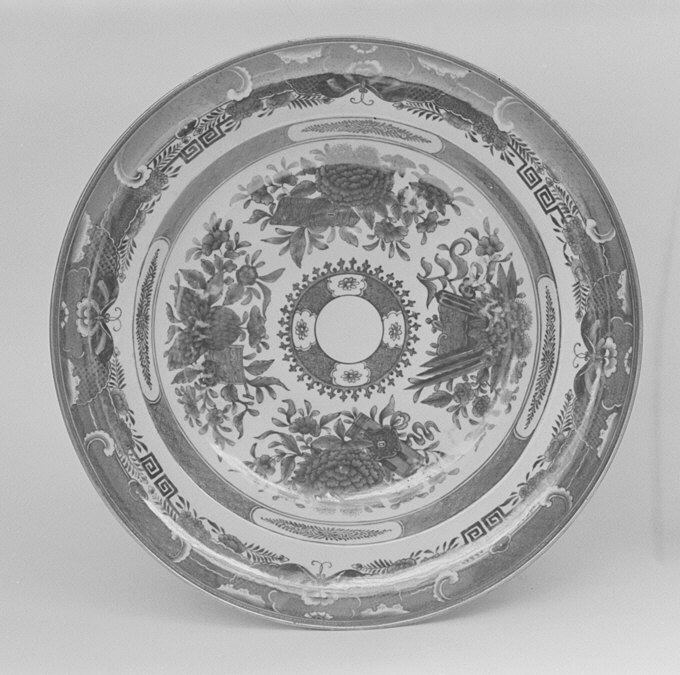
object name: soup plate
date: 1801-1833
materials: hard paste porcelain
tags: flowers